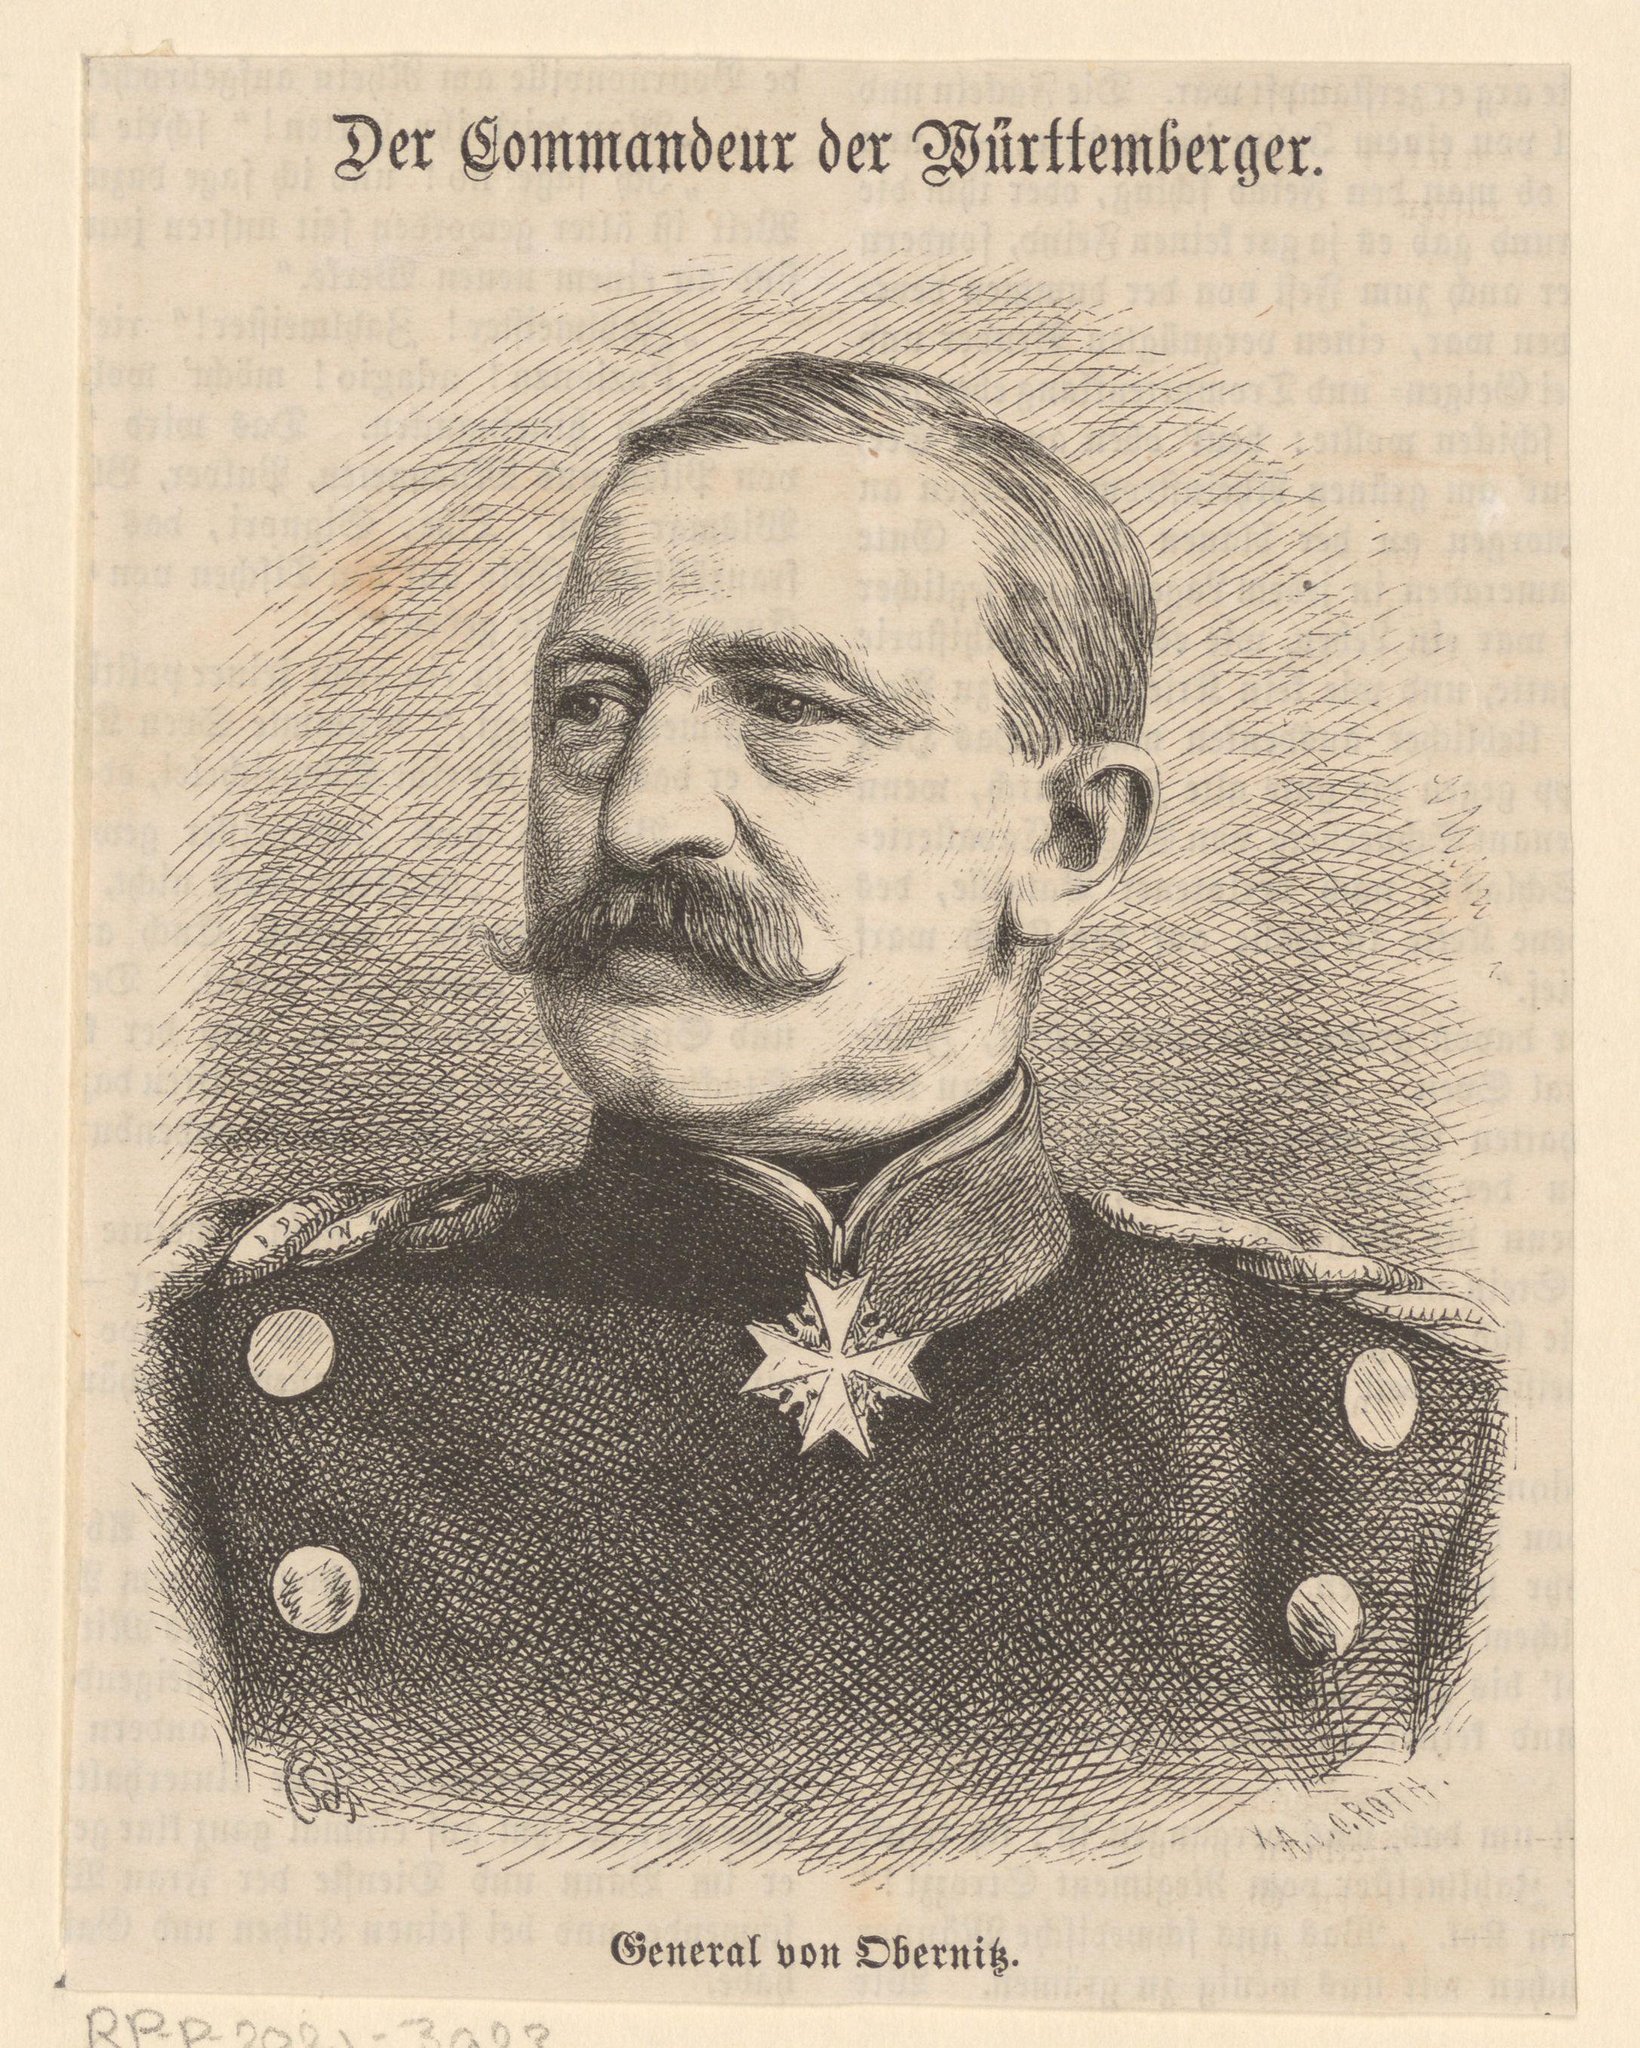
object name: print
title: Portret van Hugo von Obernitz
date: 1870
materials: paper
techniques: letterpress printing, engraving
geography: leipzig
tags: historical persons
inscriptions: stamp: ‘JVB’, signature: ‘.Sda’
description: Prent uit: Daheim 6, nr. 50, 10 september 1870.